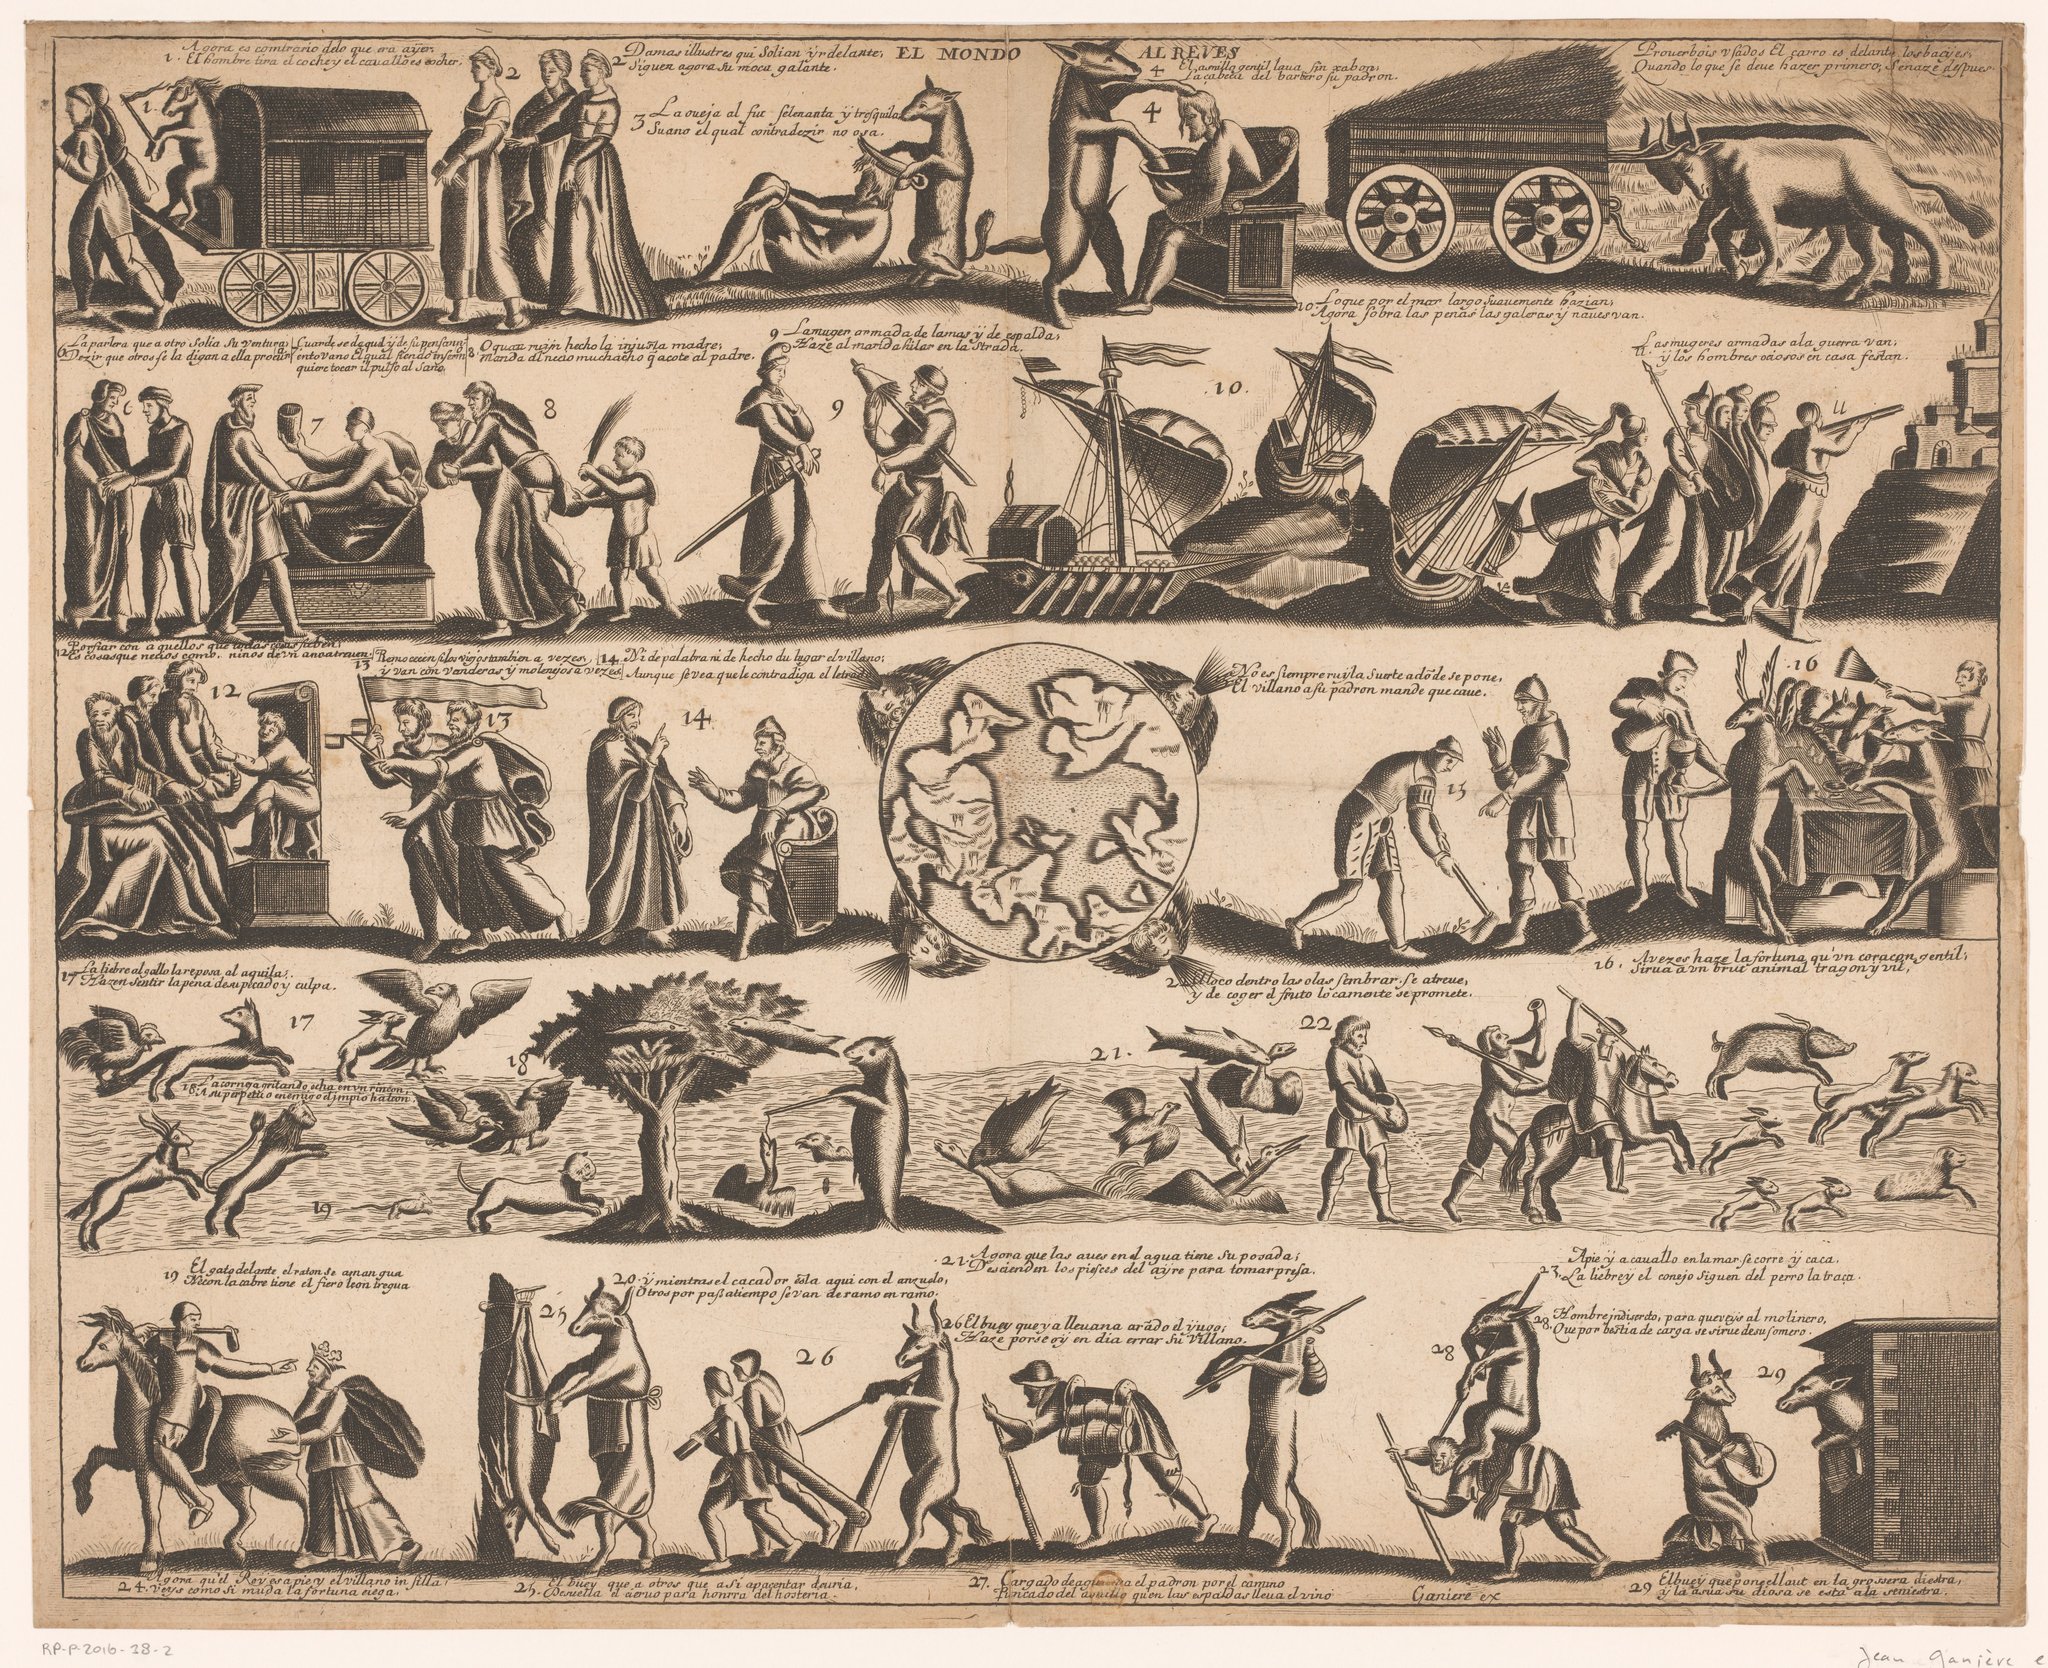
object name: print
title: El mondo al reves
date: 1625-1666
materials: paper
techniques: engraving, etching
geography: paris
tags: 'mundus inversus', the reversed world, the topsy-turvy world, 'le monde bestourné'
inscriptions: collector's mark: Lugt 2228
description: Blad met voorstellingen van het leven in de verkeerde of omgekeerde wereld, genummerd 1 t/m 29 in vijf stroken onder elkaar. Hierin ruilen dieren en mensen van plaats, bezigheden van het land naar de zee en omgekeerd, de rollen van ouders en kinderen en van meesters en knechten worden omgekeerd. In het midden een 'kaart' van de wereld. Met opschriften in het Spaans. Kopie naar de gravure uitgegeven door Nicolo Nelli in Venetië, ca. 1560.